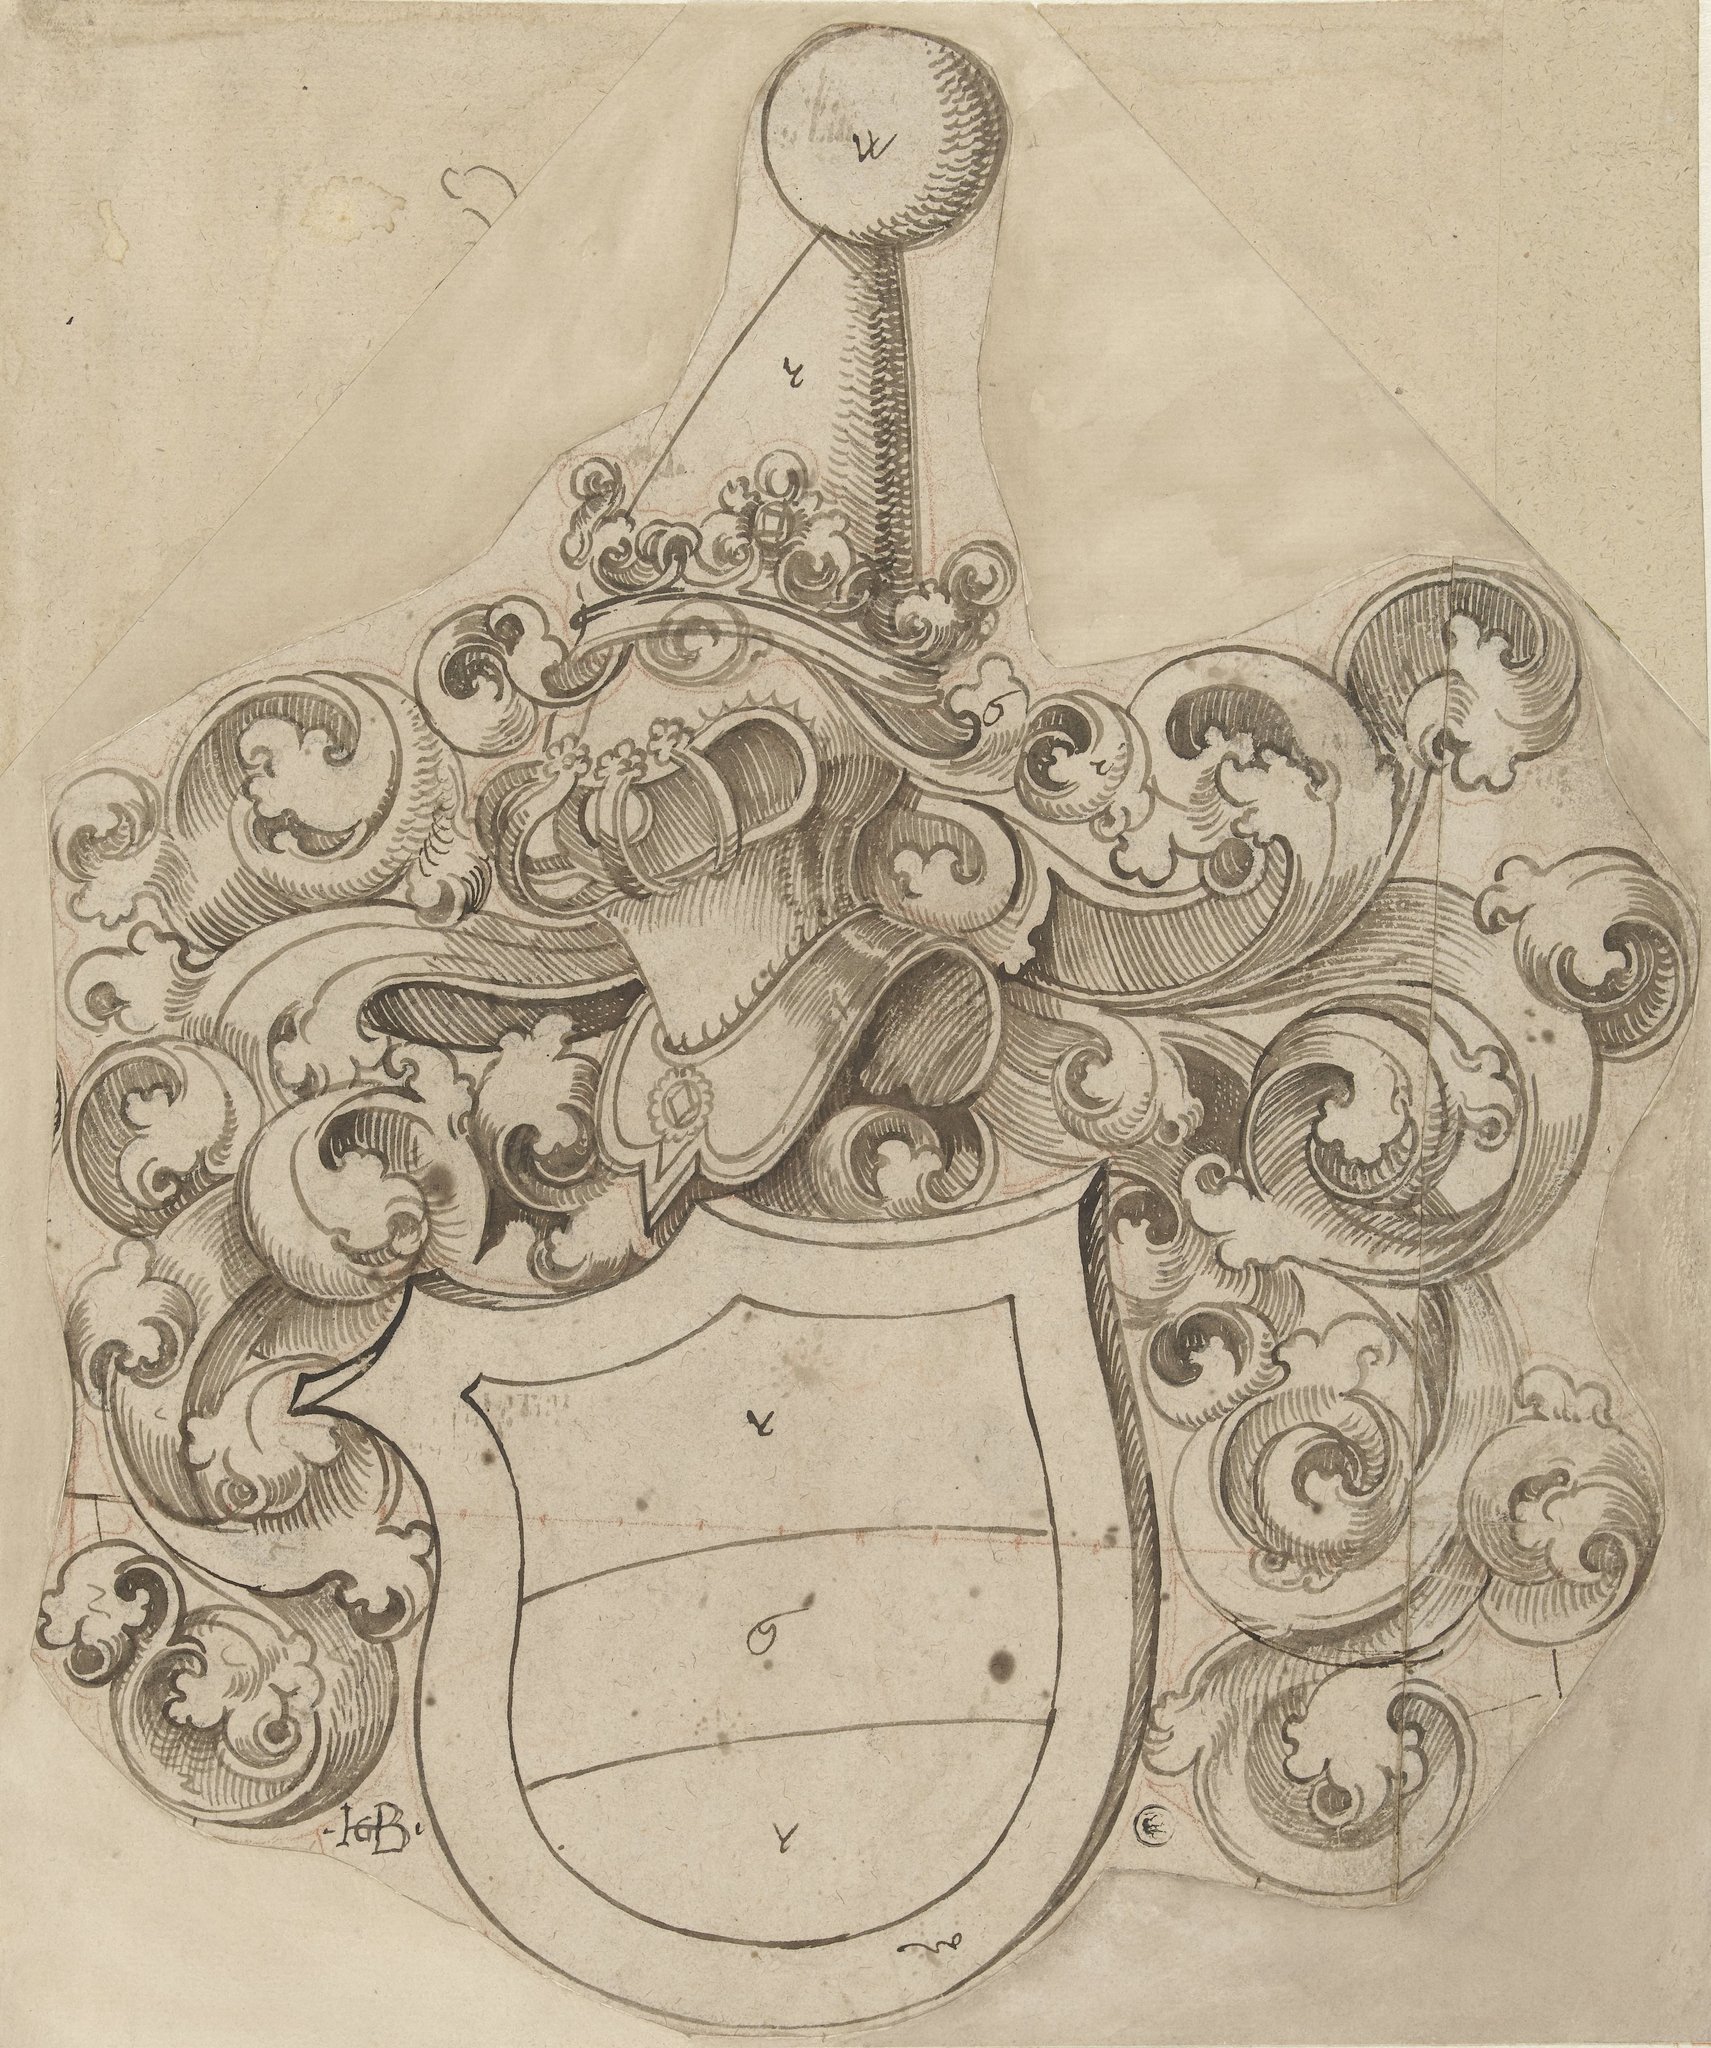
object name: drawing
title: Wapen van de familie Rathsamhausen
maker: hans baldung grien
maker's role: draughtsman, print maker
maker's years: 1484-1545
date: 1500-1560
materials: chalk, ink, paper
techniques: pen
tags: armorial bearing, heraldry